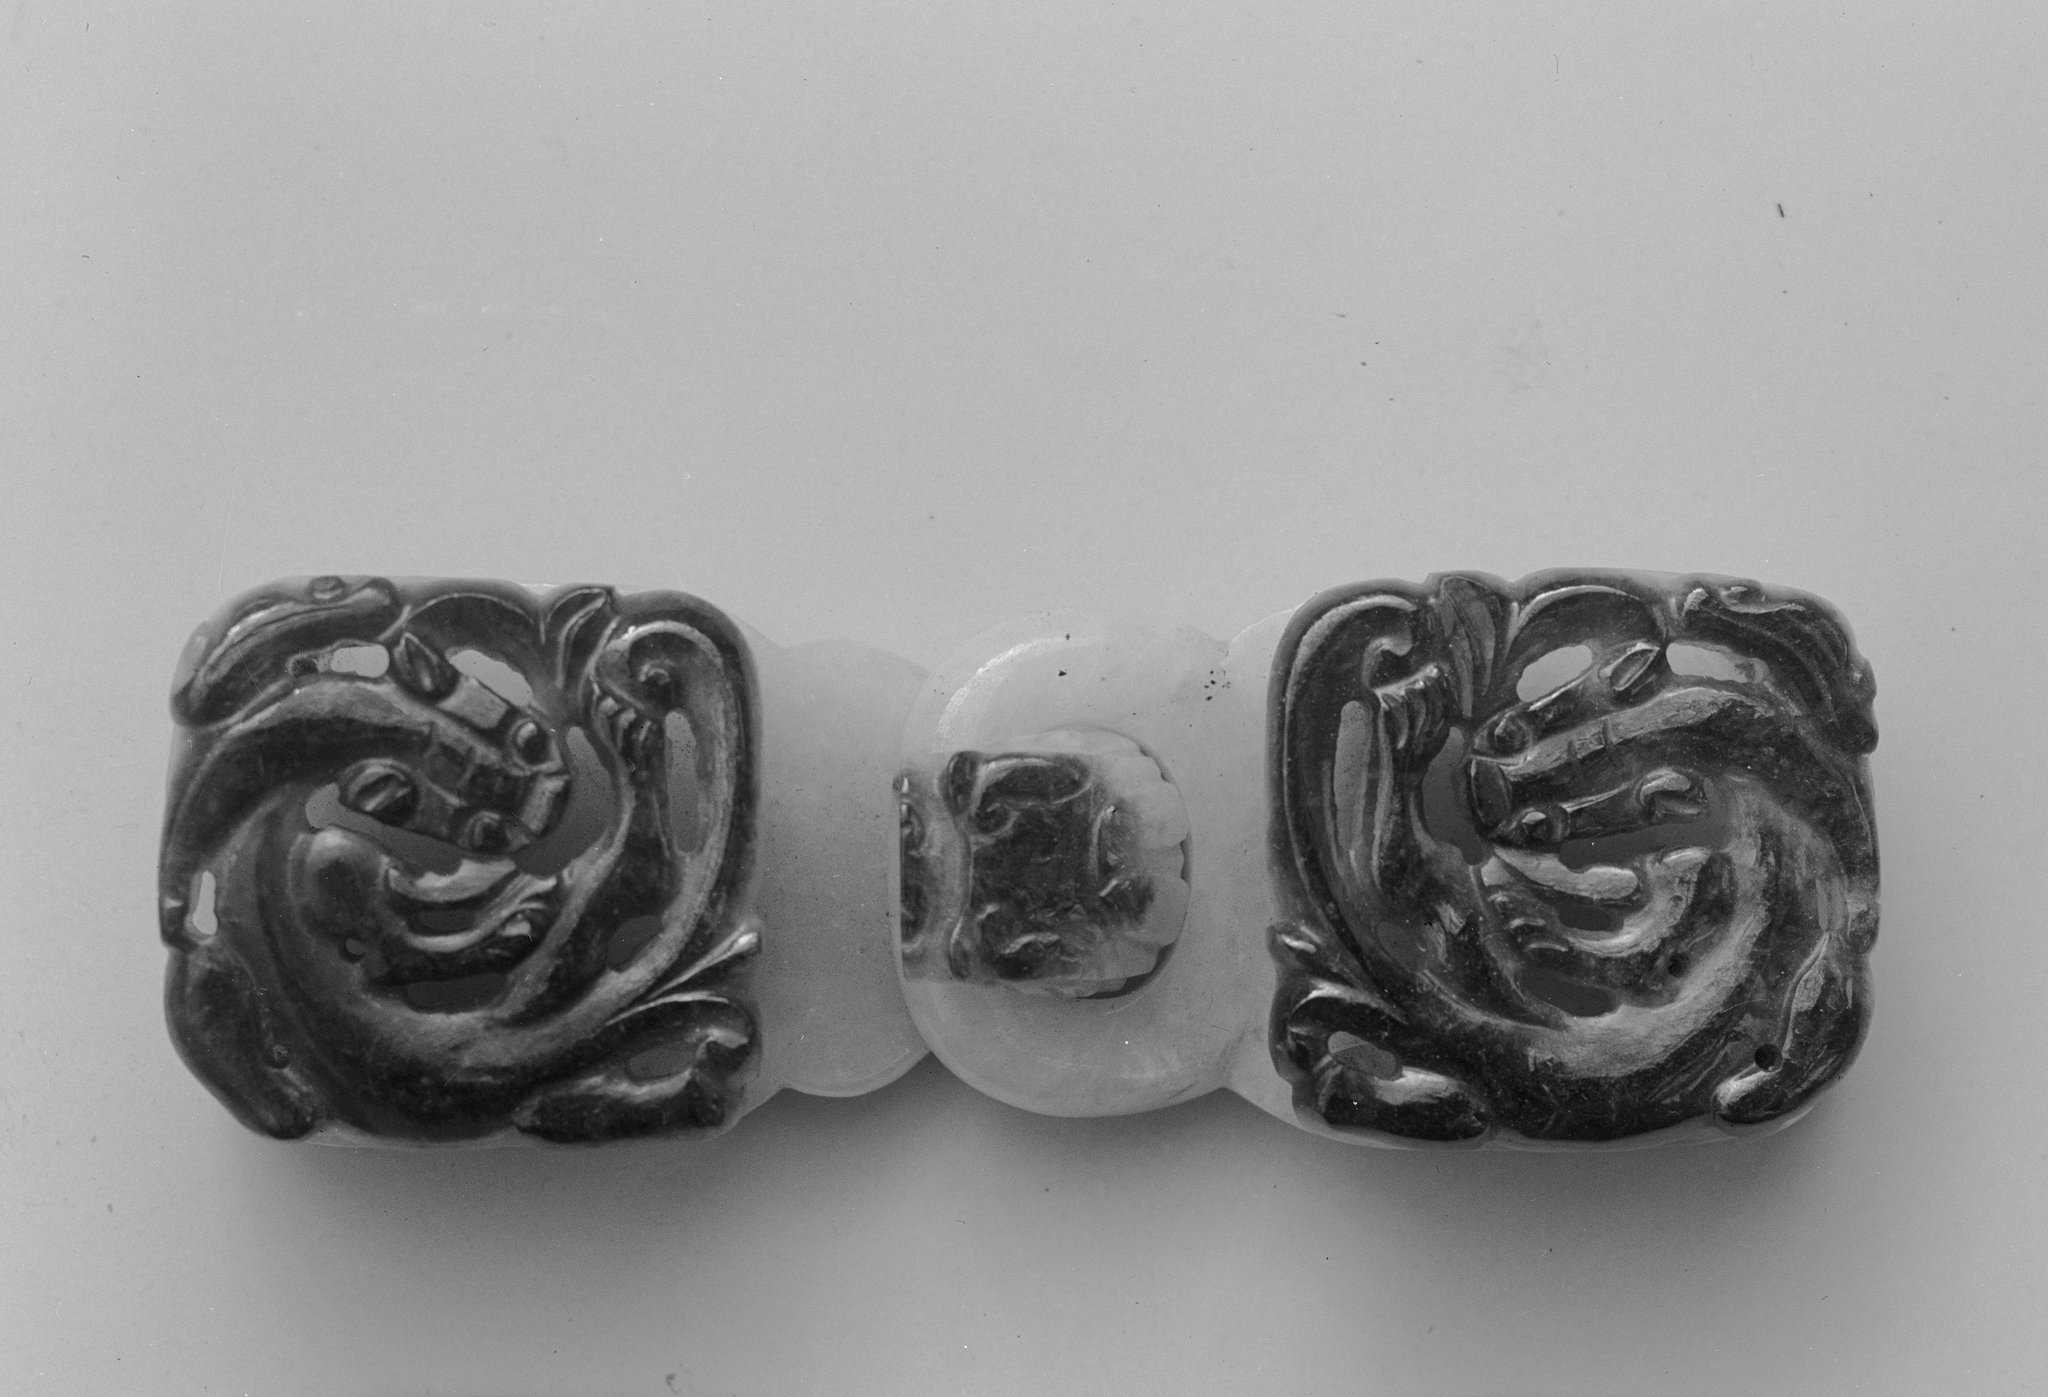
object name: buckle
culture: chinese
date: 1736-1795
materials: gemstone, jade